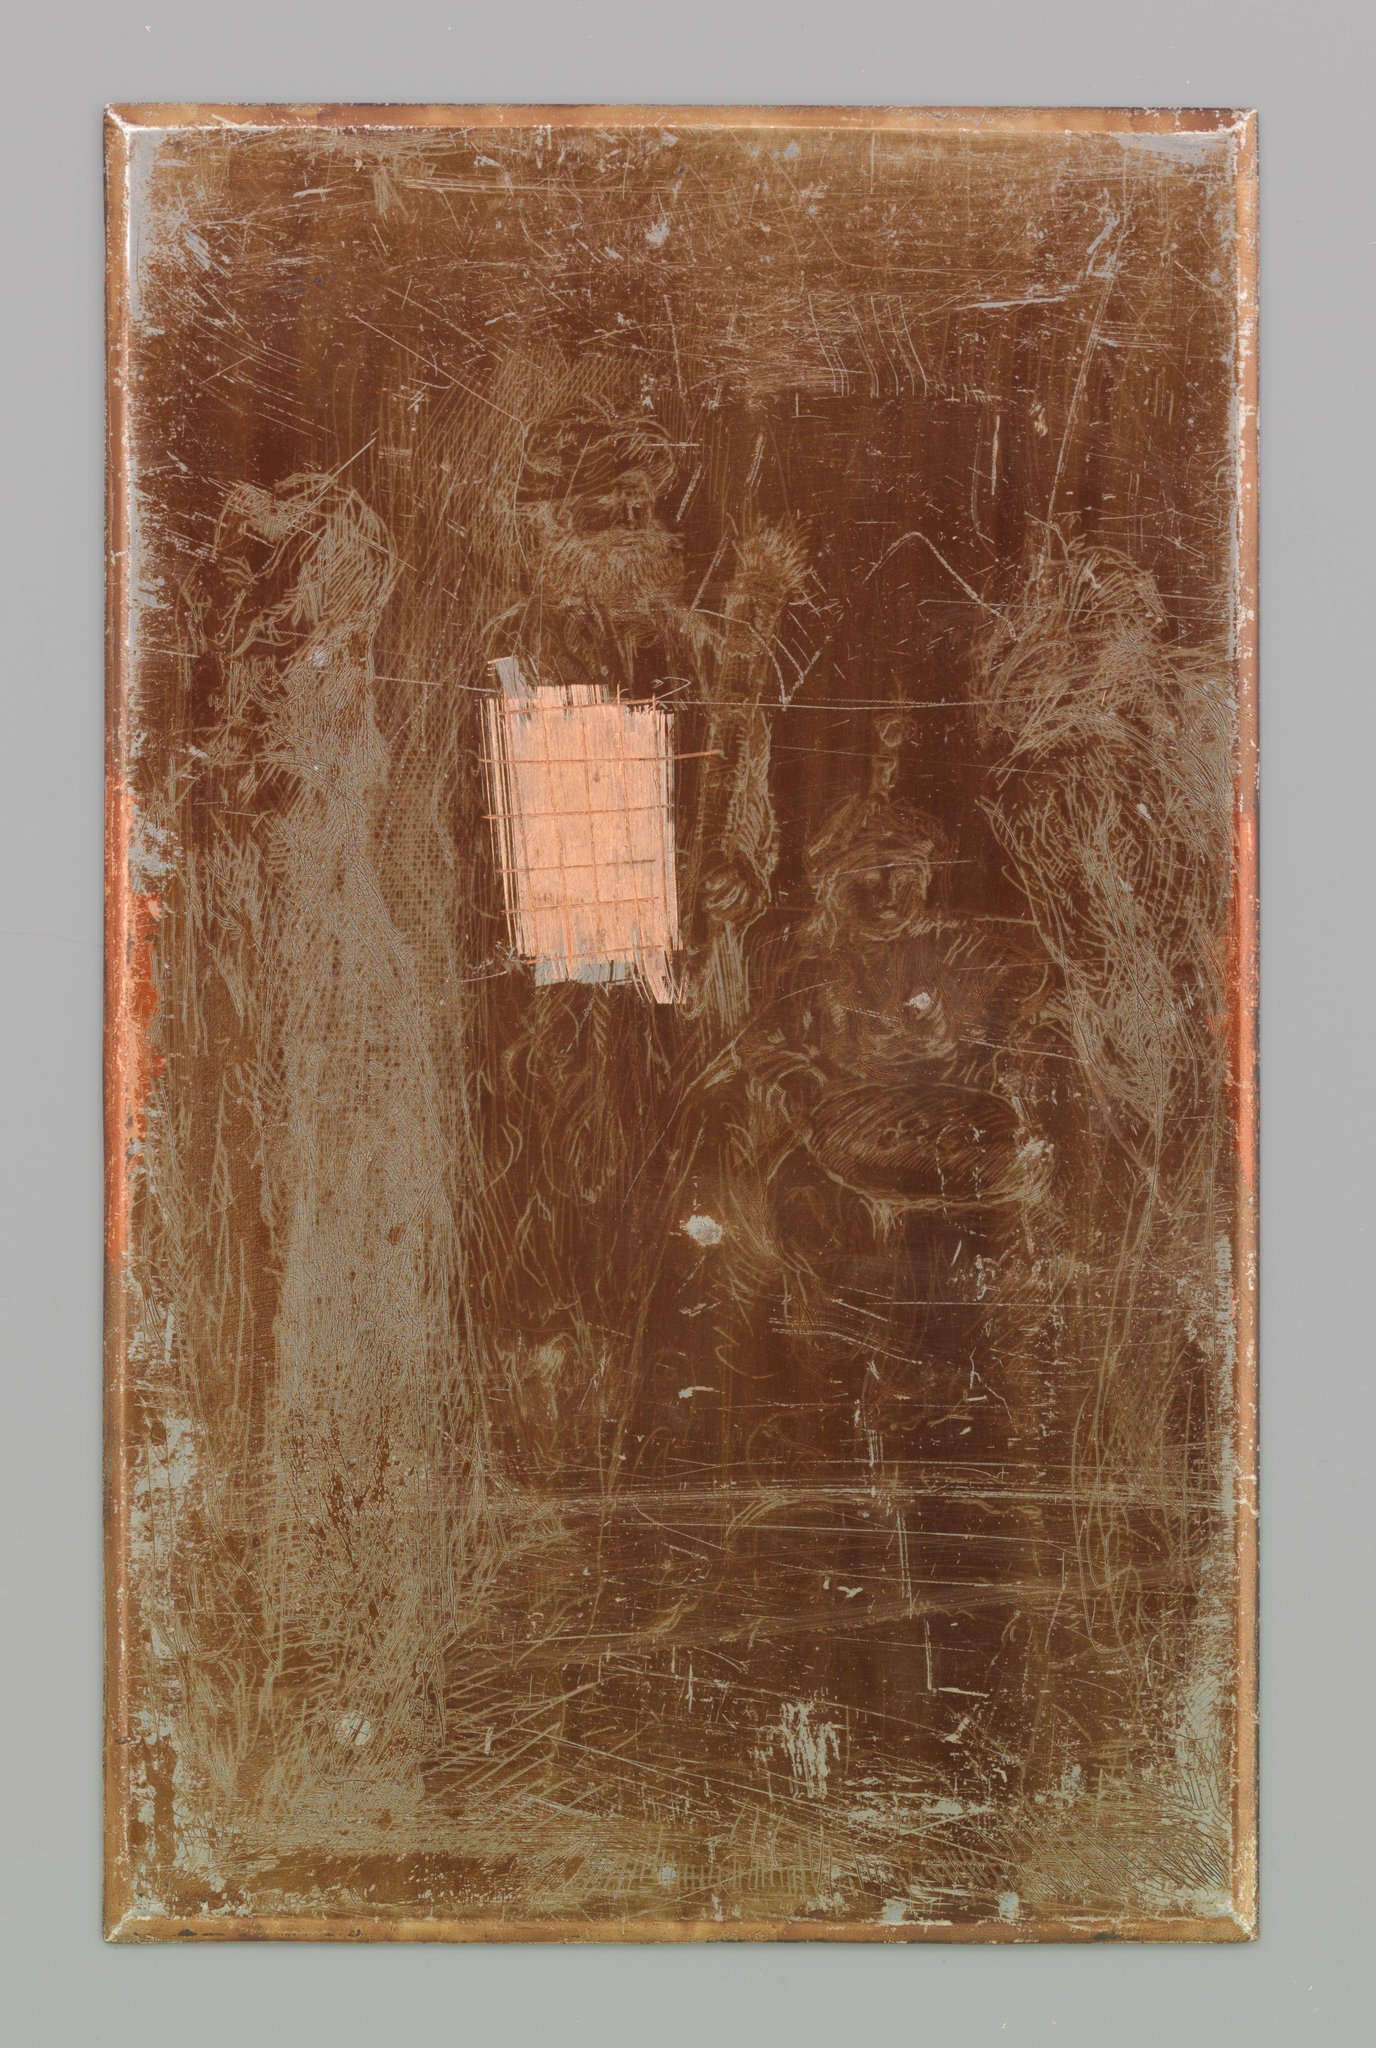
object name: copper plate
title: Oosterse prinses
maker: marius bauer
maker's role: draughtsman, print maker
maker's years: 1867-1932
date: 1877-1932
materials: copper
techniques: etching